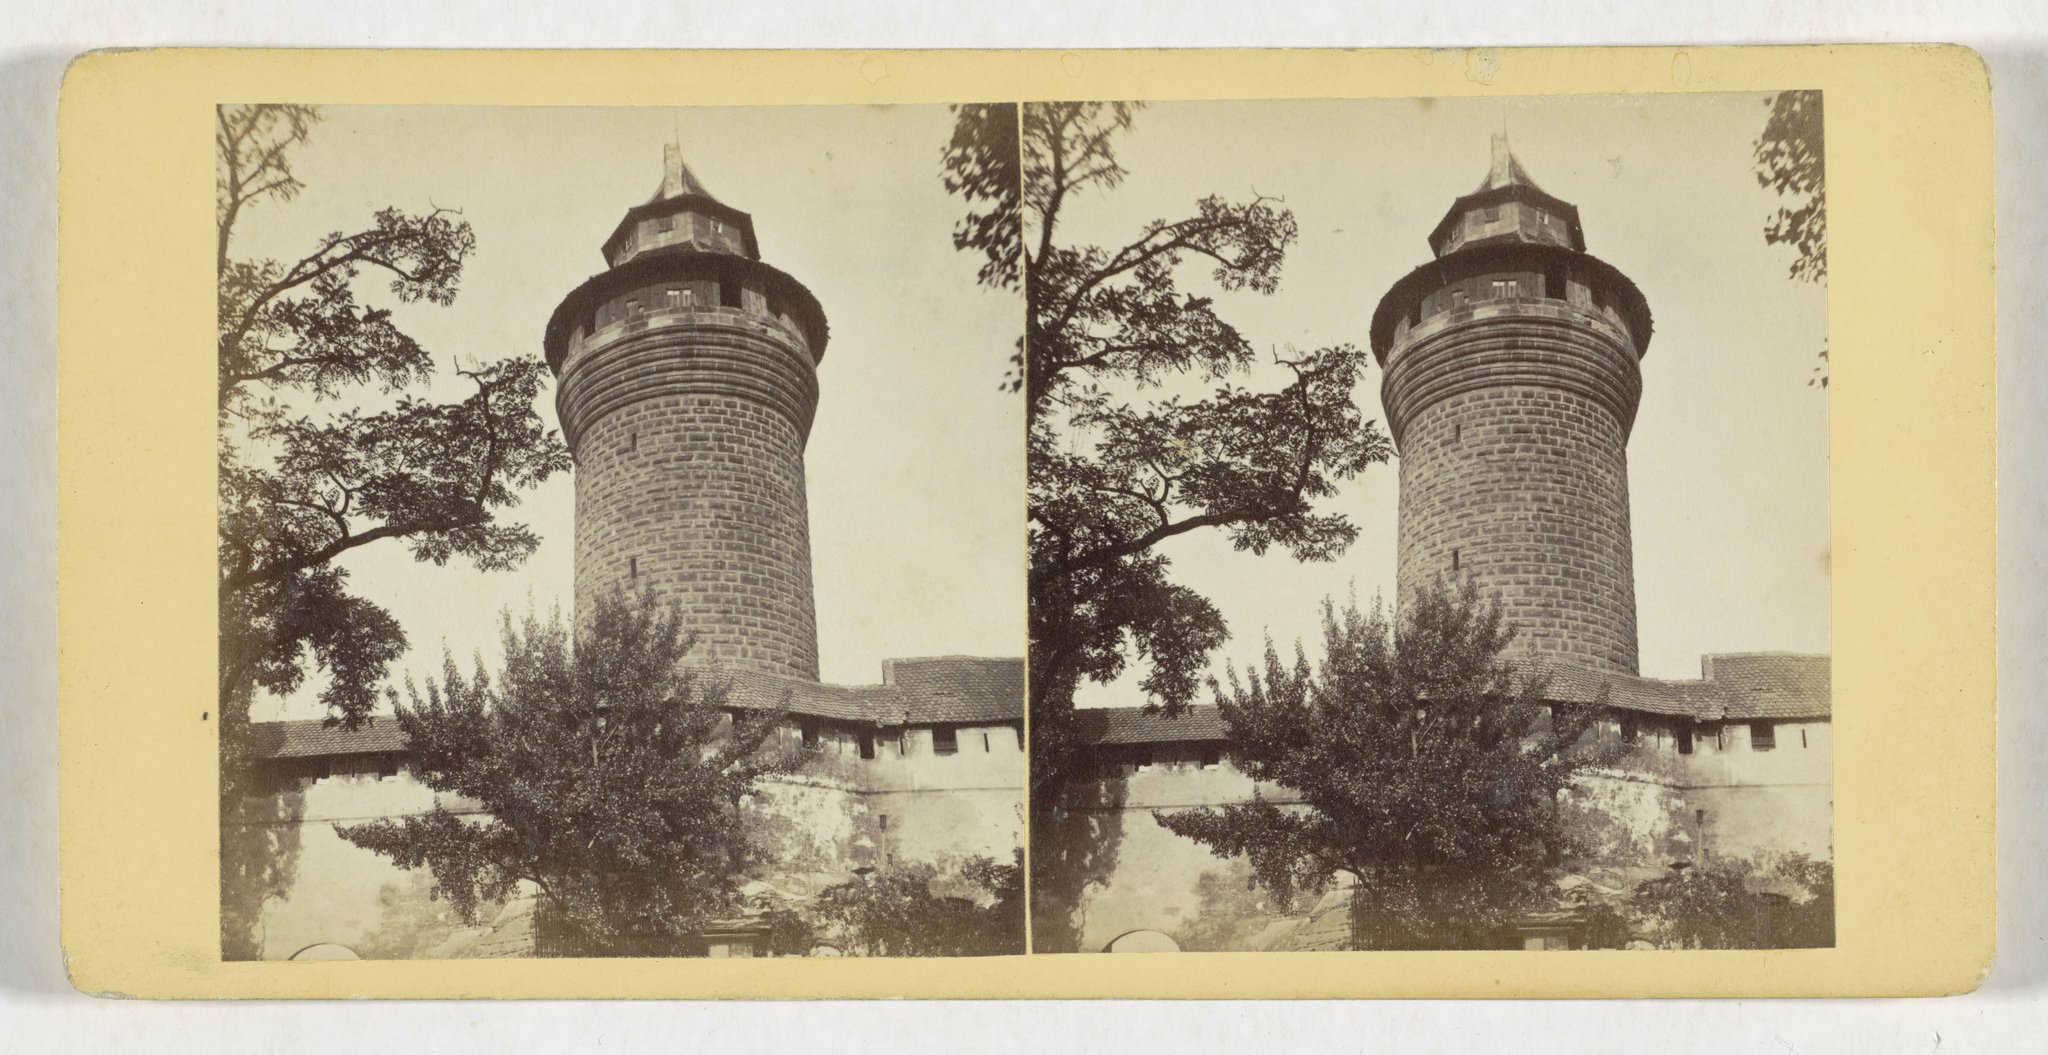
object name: stereograph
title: Vestner Thurm auf der Burg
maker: johann friedrich stiehm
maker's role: fotograaf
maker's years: 1826-1902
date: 1868-1888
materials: cardboard, paper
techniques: albumen print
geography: london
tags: towers ~ fortified city, tower (of house or building)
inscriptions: number: ‘No. 17.’